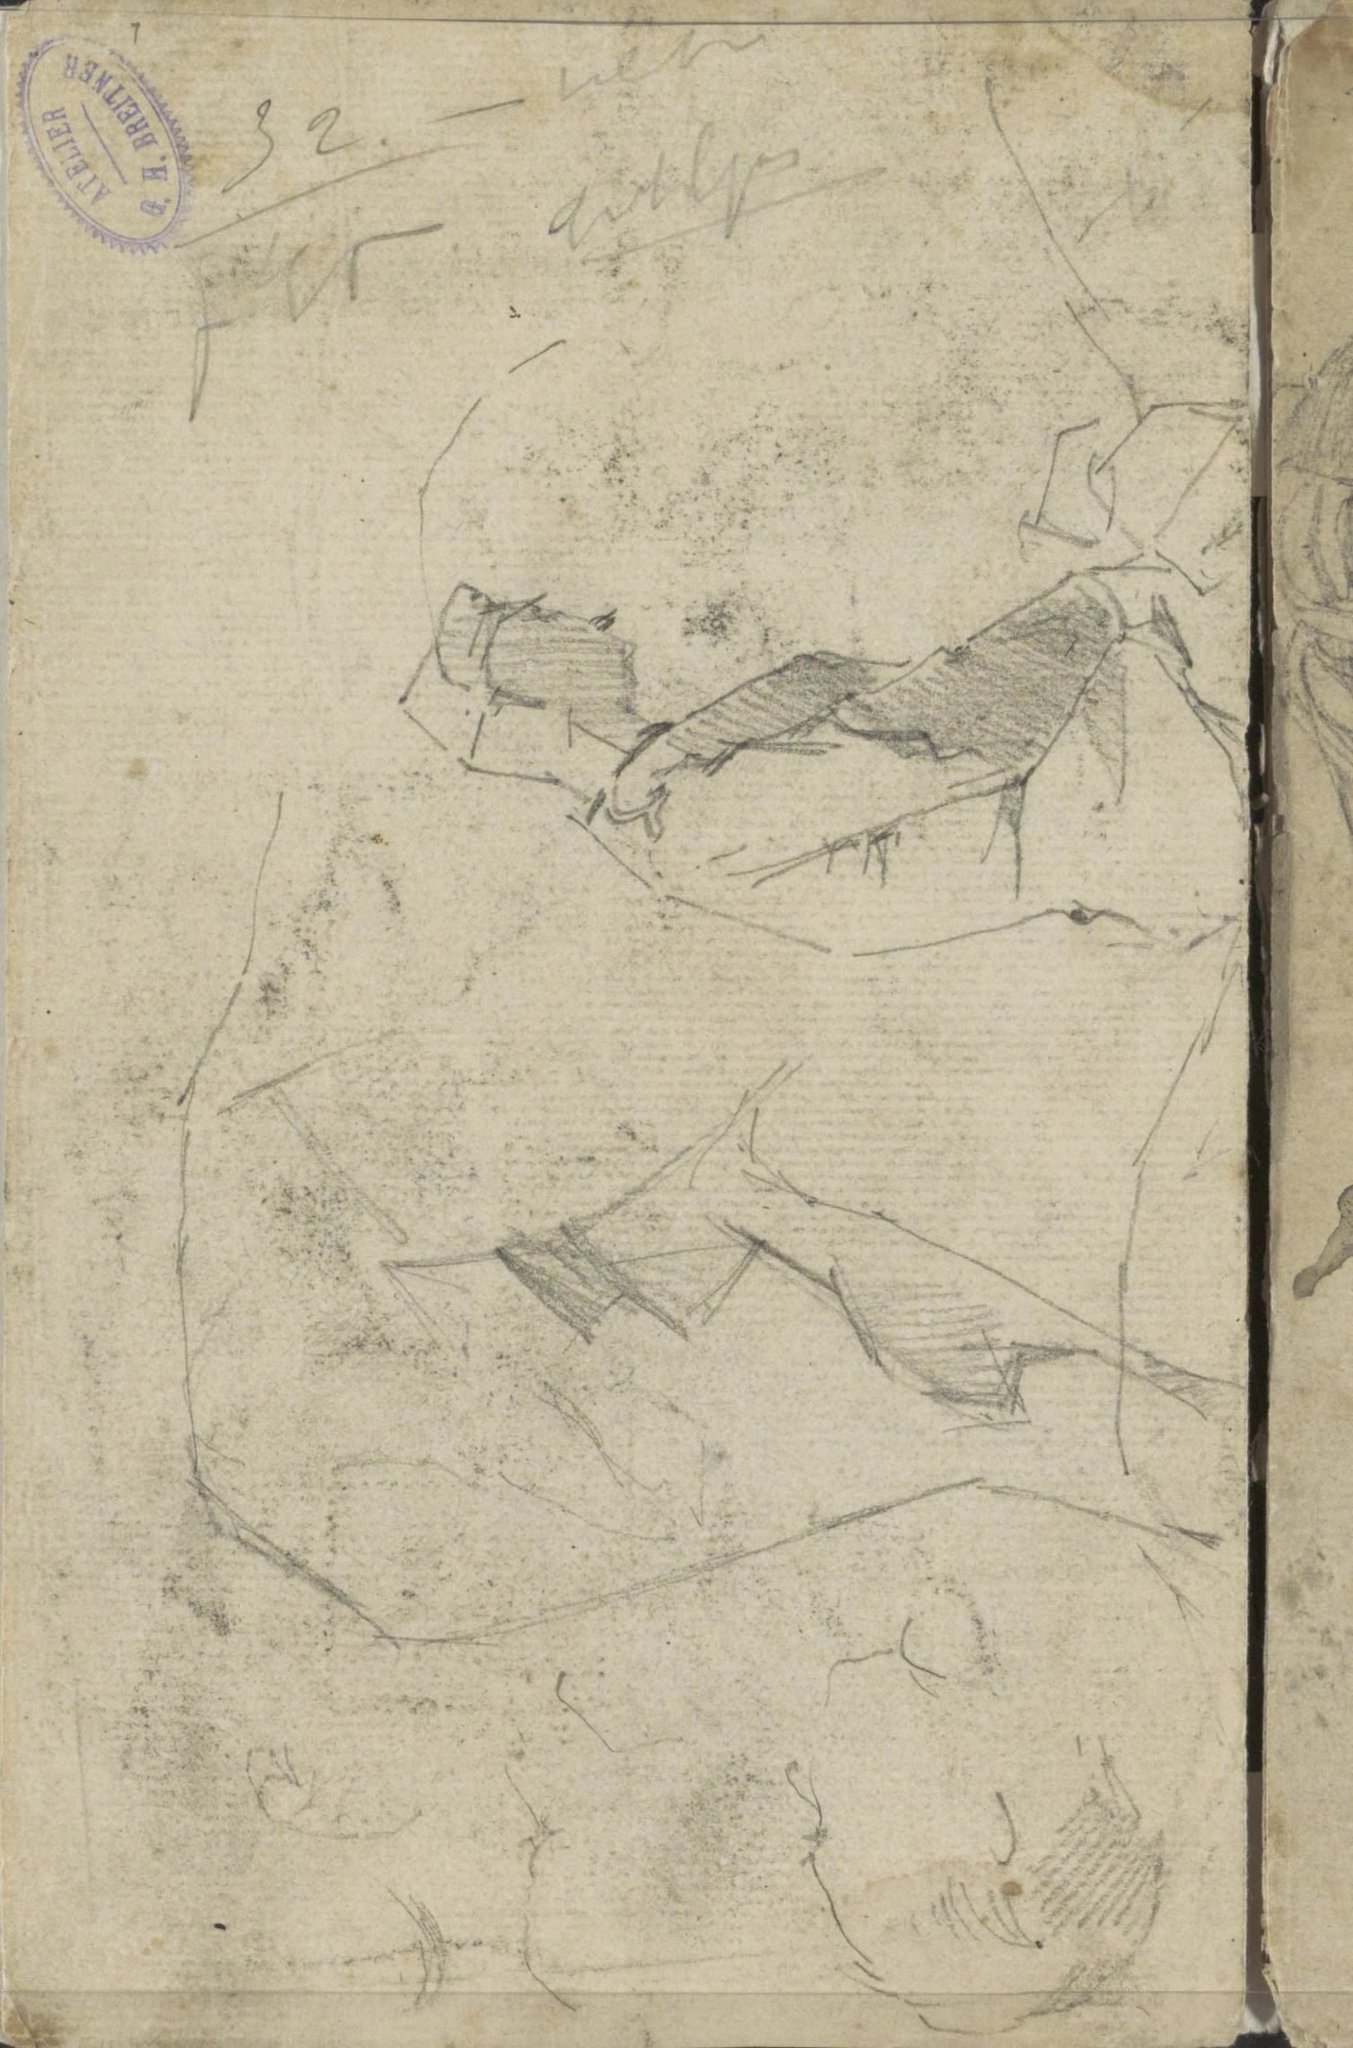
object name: sketchbook leaf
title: Studieblad met een ruiter, een paard en een mannenhoofd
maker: george hendrik breitner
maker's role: draughtsman, painter, print maker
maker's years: 1857-1923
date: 1881-1883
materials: chalk, paper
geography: the hague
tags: riding a horse, ass, or mule; rider, horseman, head (human), horse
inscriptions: workshop stamp: Lugt 291d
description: Pagina 7 uit een schetsboek met 9 bladen.